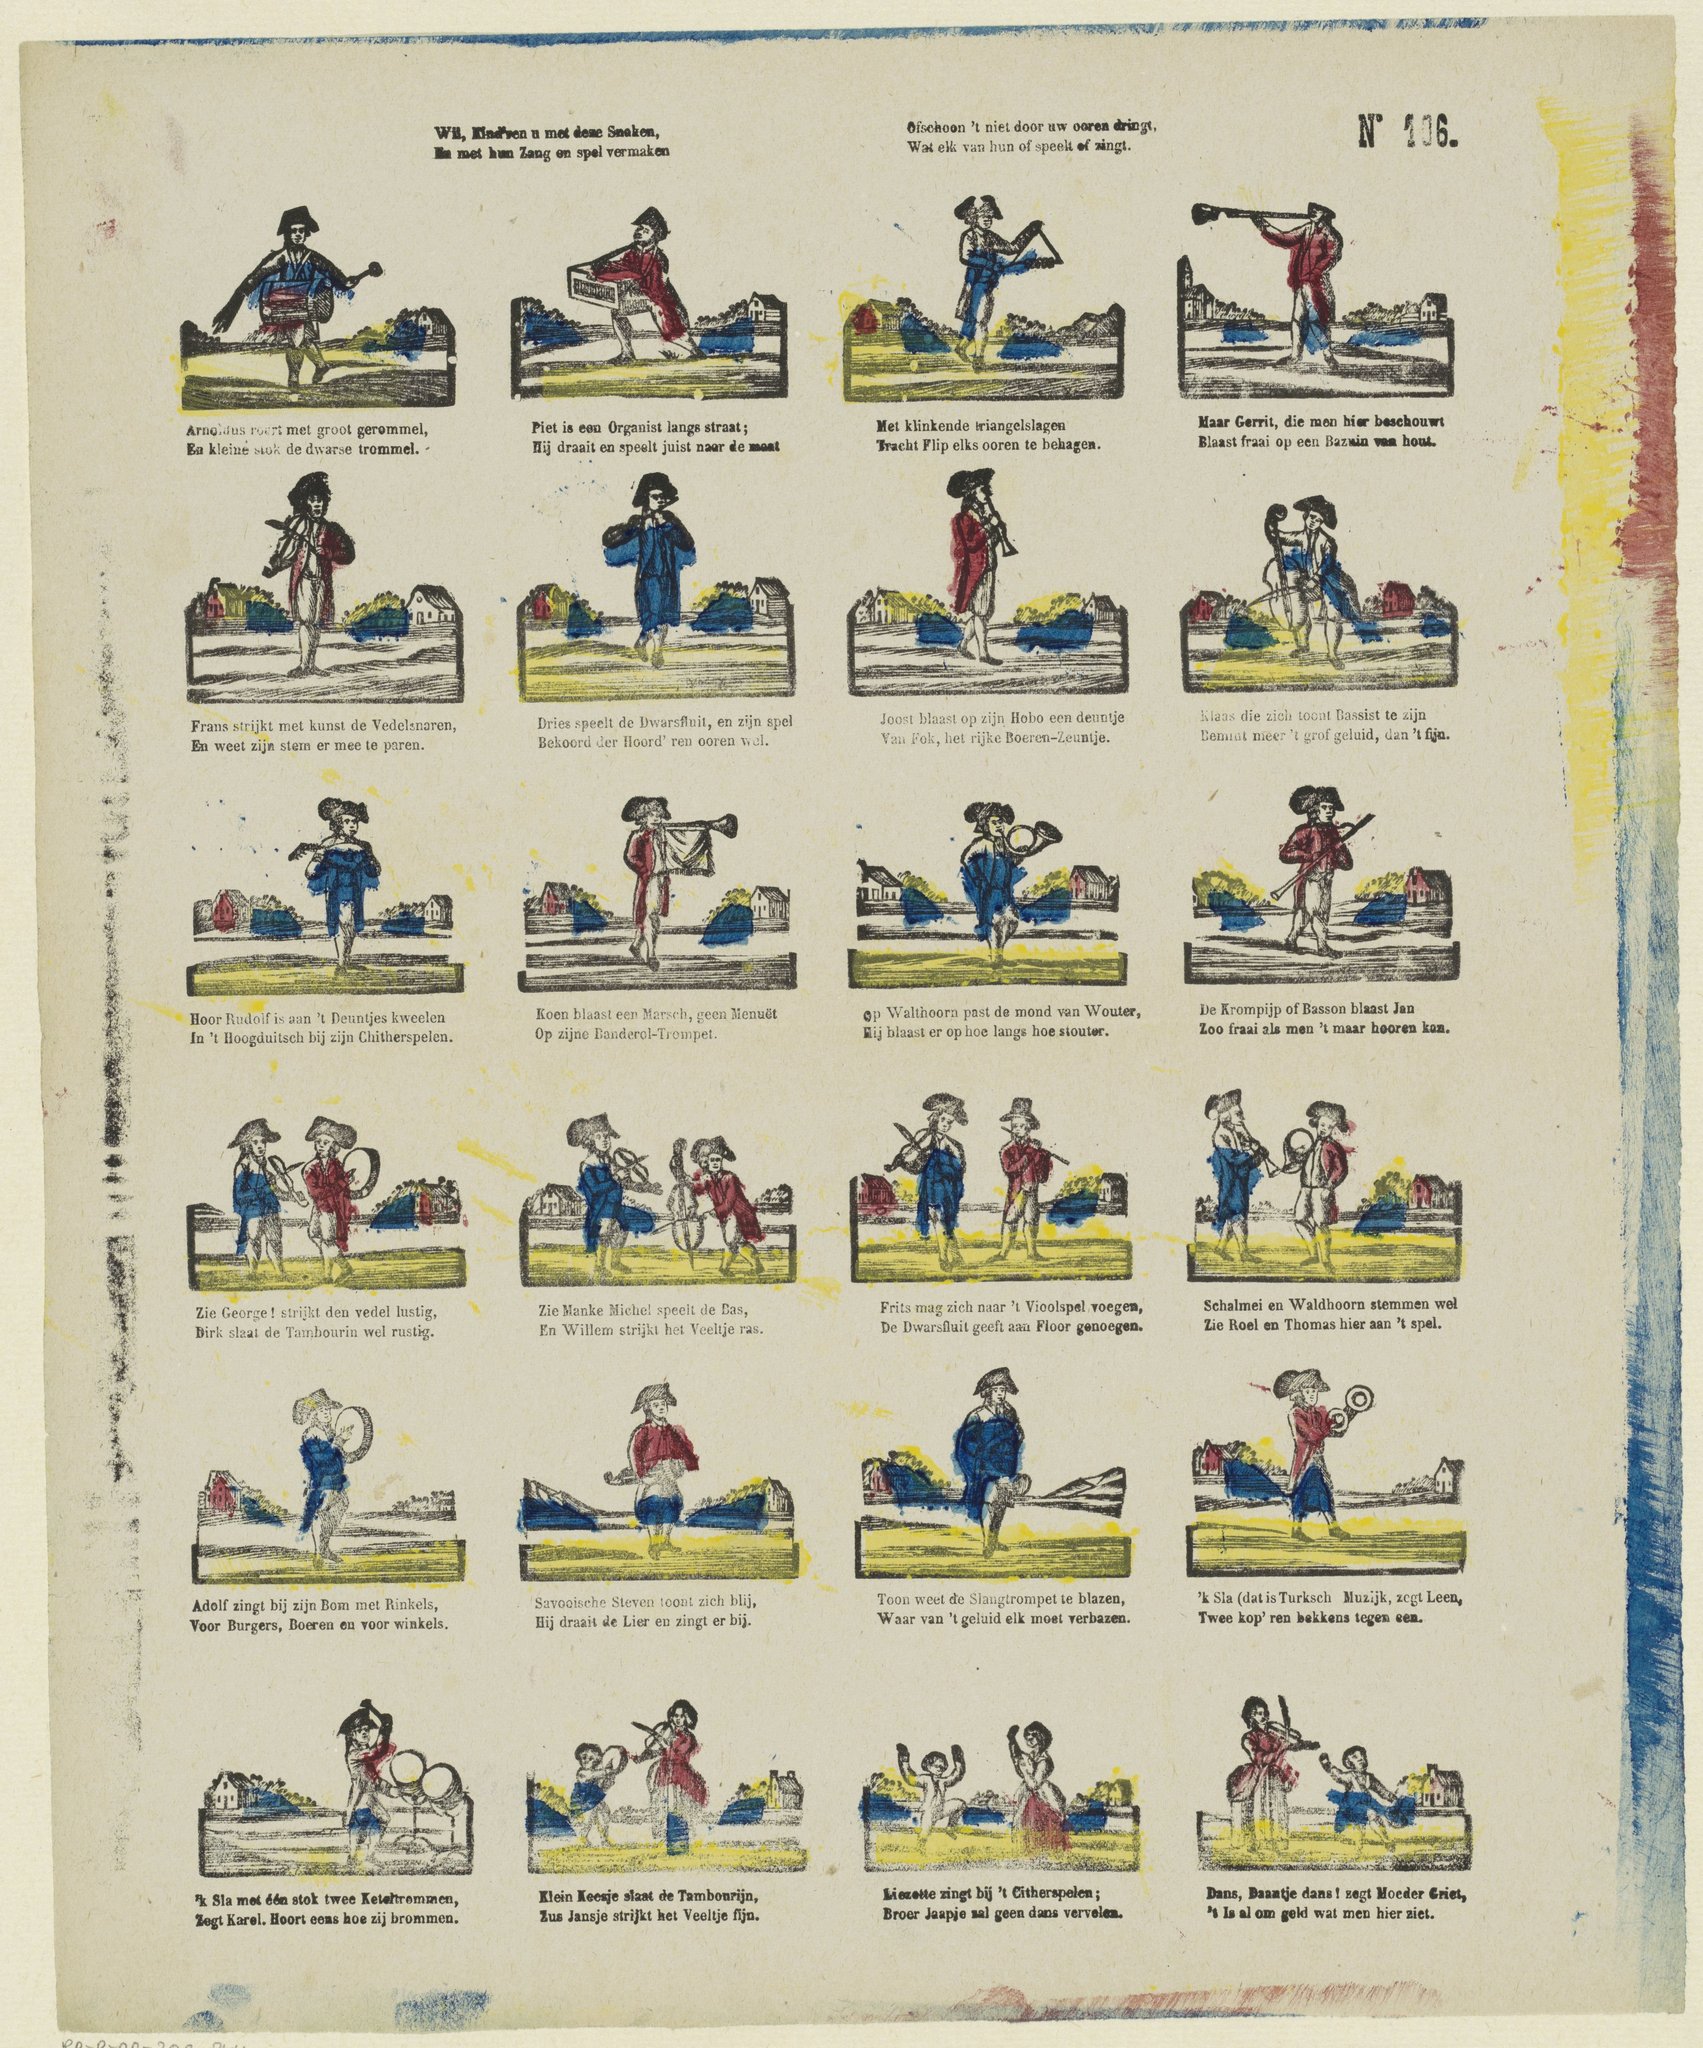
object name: popular print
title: Wij, kind'ren u met deze snaken, / En met hun zang en spel vermaken / Ofschoon 't niet door uw ooren dringt, / Wat elk van hun of speelt of zingt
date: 1827-1894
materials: paper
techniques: colour, letterpress printing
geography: schaarbeek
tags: musician, musician - cc - out of doors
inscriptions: collector's mark: Lugt 2760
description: Blad met 24 voorstellingen van muzikanten. Onder elke afbeelding een tweeregelig vers. Genummerd rechtsboven: No. 106.